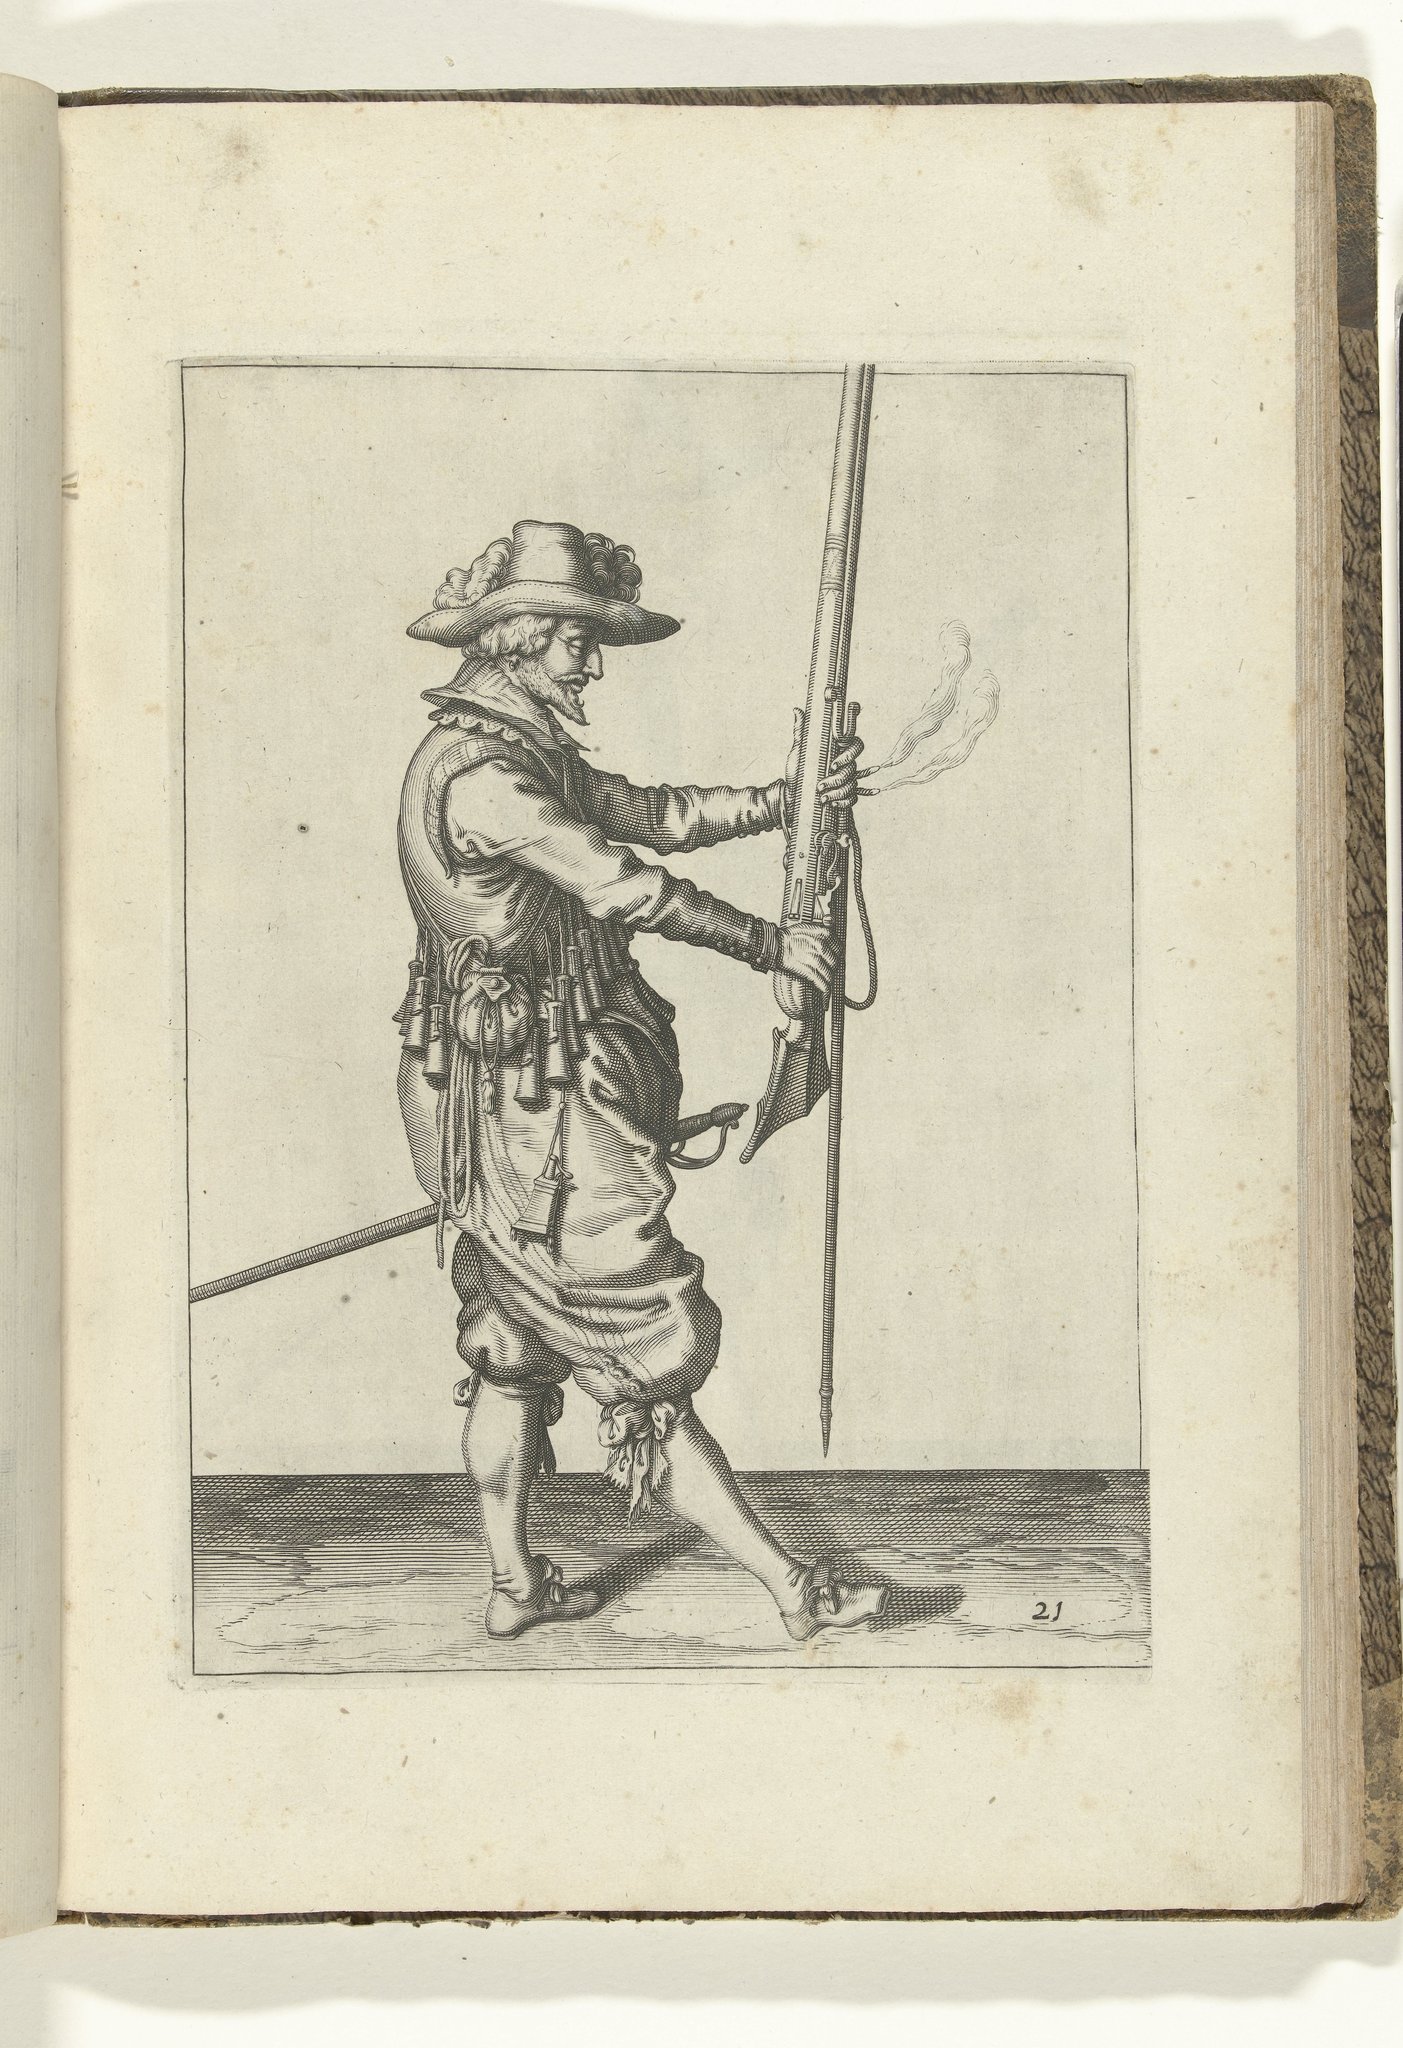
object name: print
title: Soldaat die zijn musket met beide handen rechtop voor zich vasthoudt (nr. 21), ca. 1600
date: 1597-1608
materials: paper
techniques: engraving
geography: northern netherlands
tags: the hague, maurice (prince of orange), handling of weapons ~ military training, weapons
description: Een soldaat, ten voeten uit, naar rechts, die een musket (een bepaald type vuurwapen) met beide handen voor zich vasthoudt, de loop omhoog wijzend, om het naar zijn linkerzijde te brengen (nr. 21), ca. 1600. In zijn linkerhand behalve de loop van het musket ook een furket (musketvork) en een brandende lont. Plaat 21 in de instructies voor het hanteren van het musket: Brief enseignement, sur les pourtraitz figurez, touchant le droit maniement du Mousquet. Onderdeel van de illustraties in een Franse editie van J. de Gheyns Wapenhandelinghe: J. de Gheyn, Maniement d'armes, d'arquebuses, mousquetz et piques : en conformité de l'ordre de Mour le Prince Maurice, Prince d'Orange, Amsterdam 1608. Krijgswezen rond 1600.